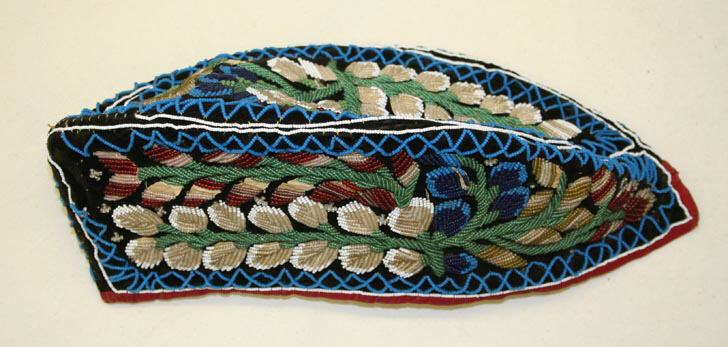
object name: glengarry cap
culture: american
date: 1850-1869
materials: cotton